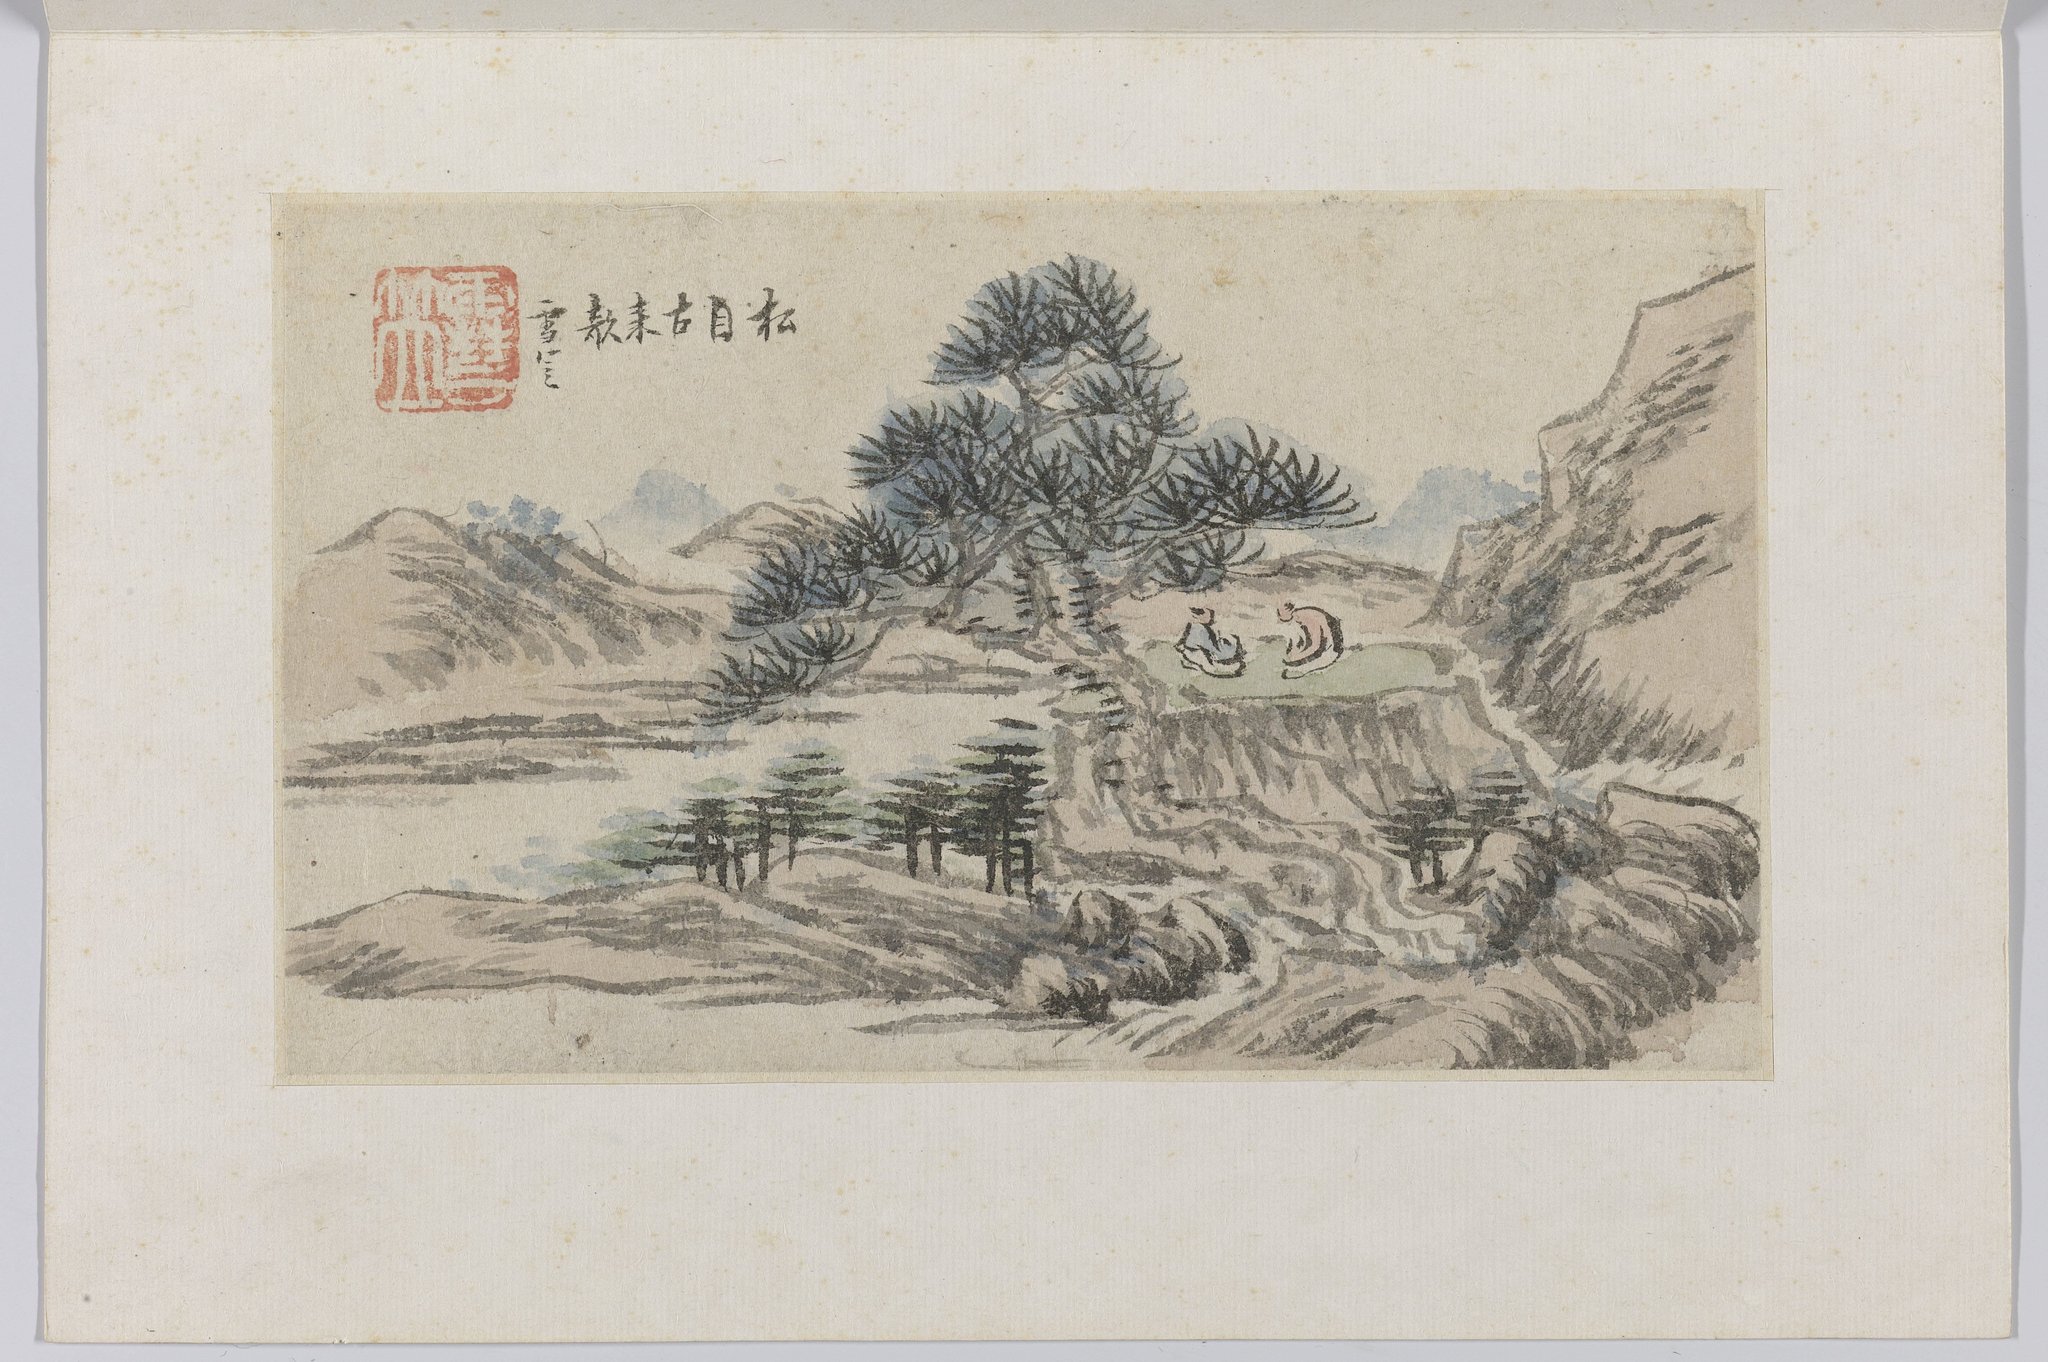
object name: album leaf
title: Landschap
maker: cheng men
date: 1850-1900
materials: ink, paper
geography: shexian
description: Albumblad met een landschap. Gesigneerd door Cheng Men, bekend als porseleinschilder in Jingdezhen.